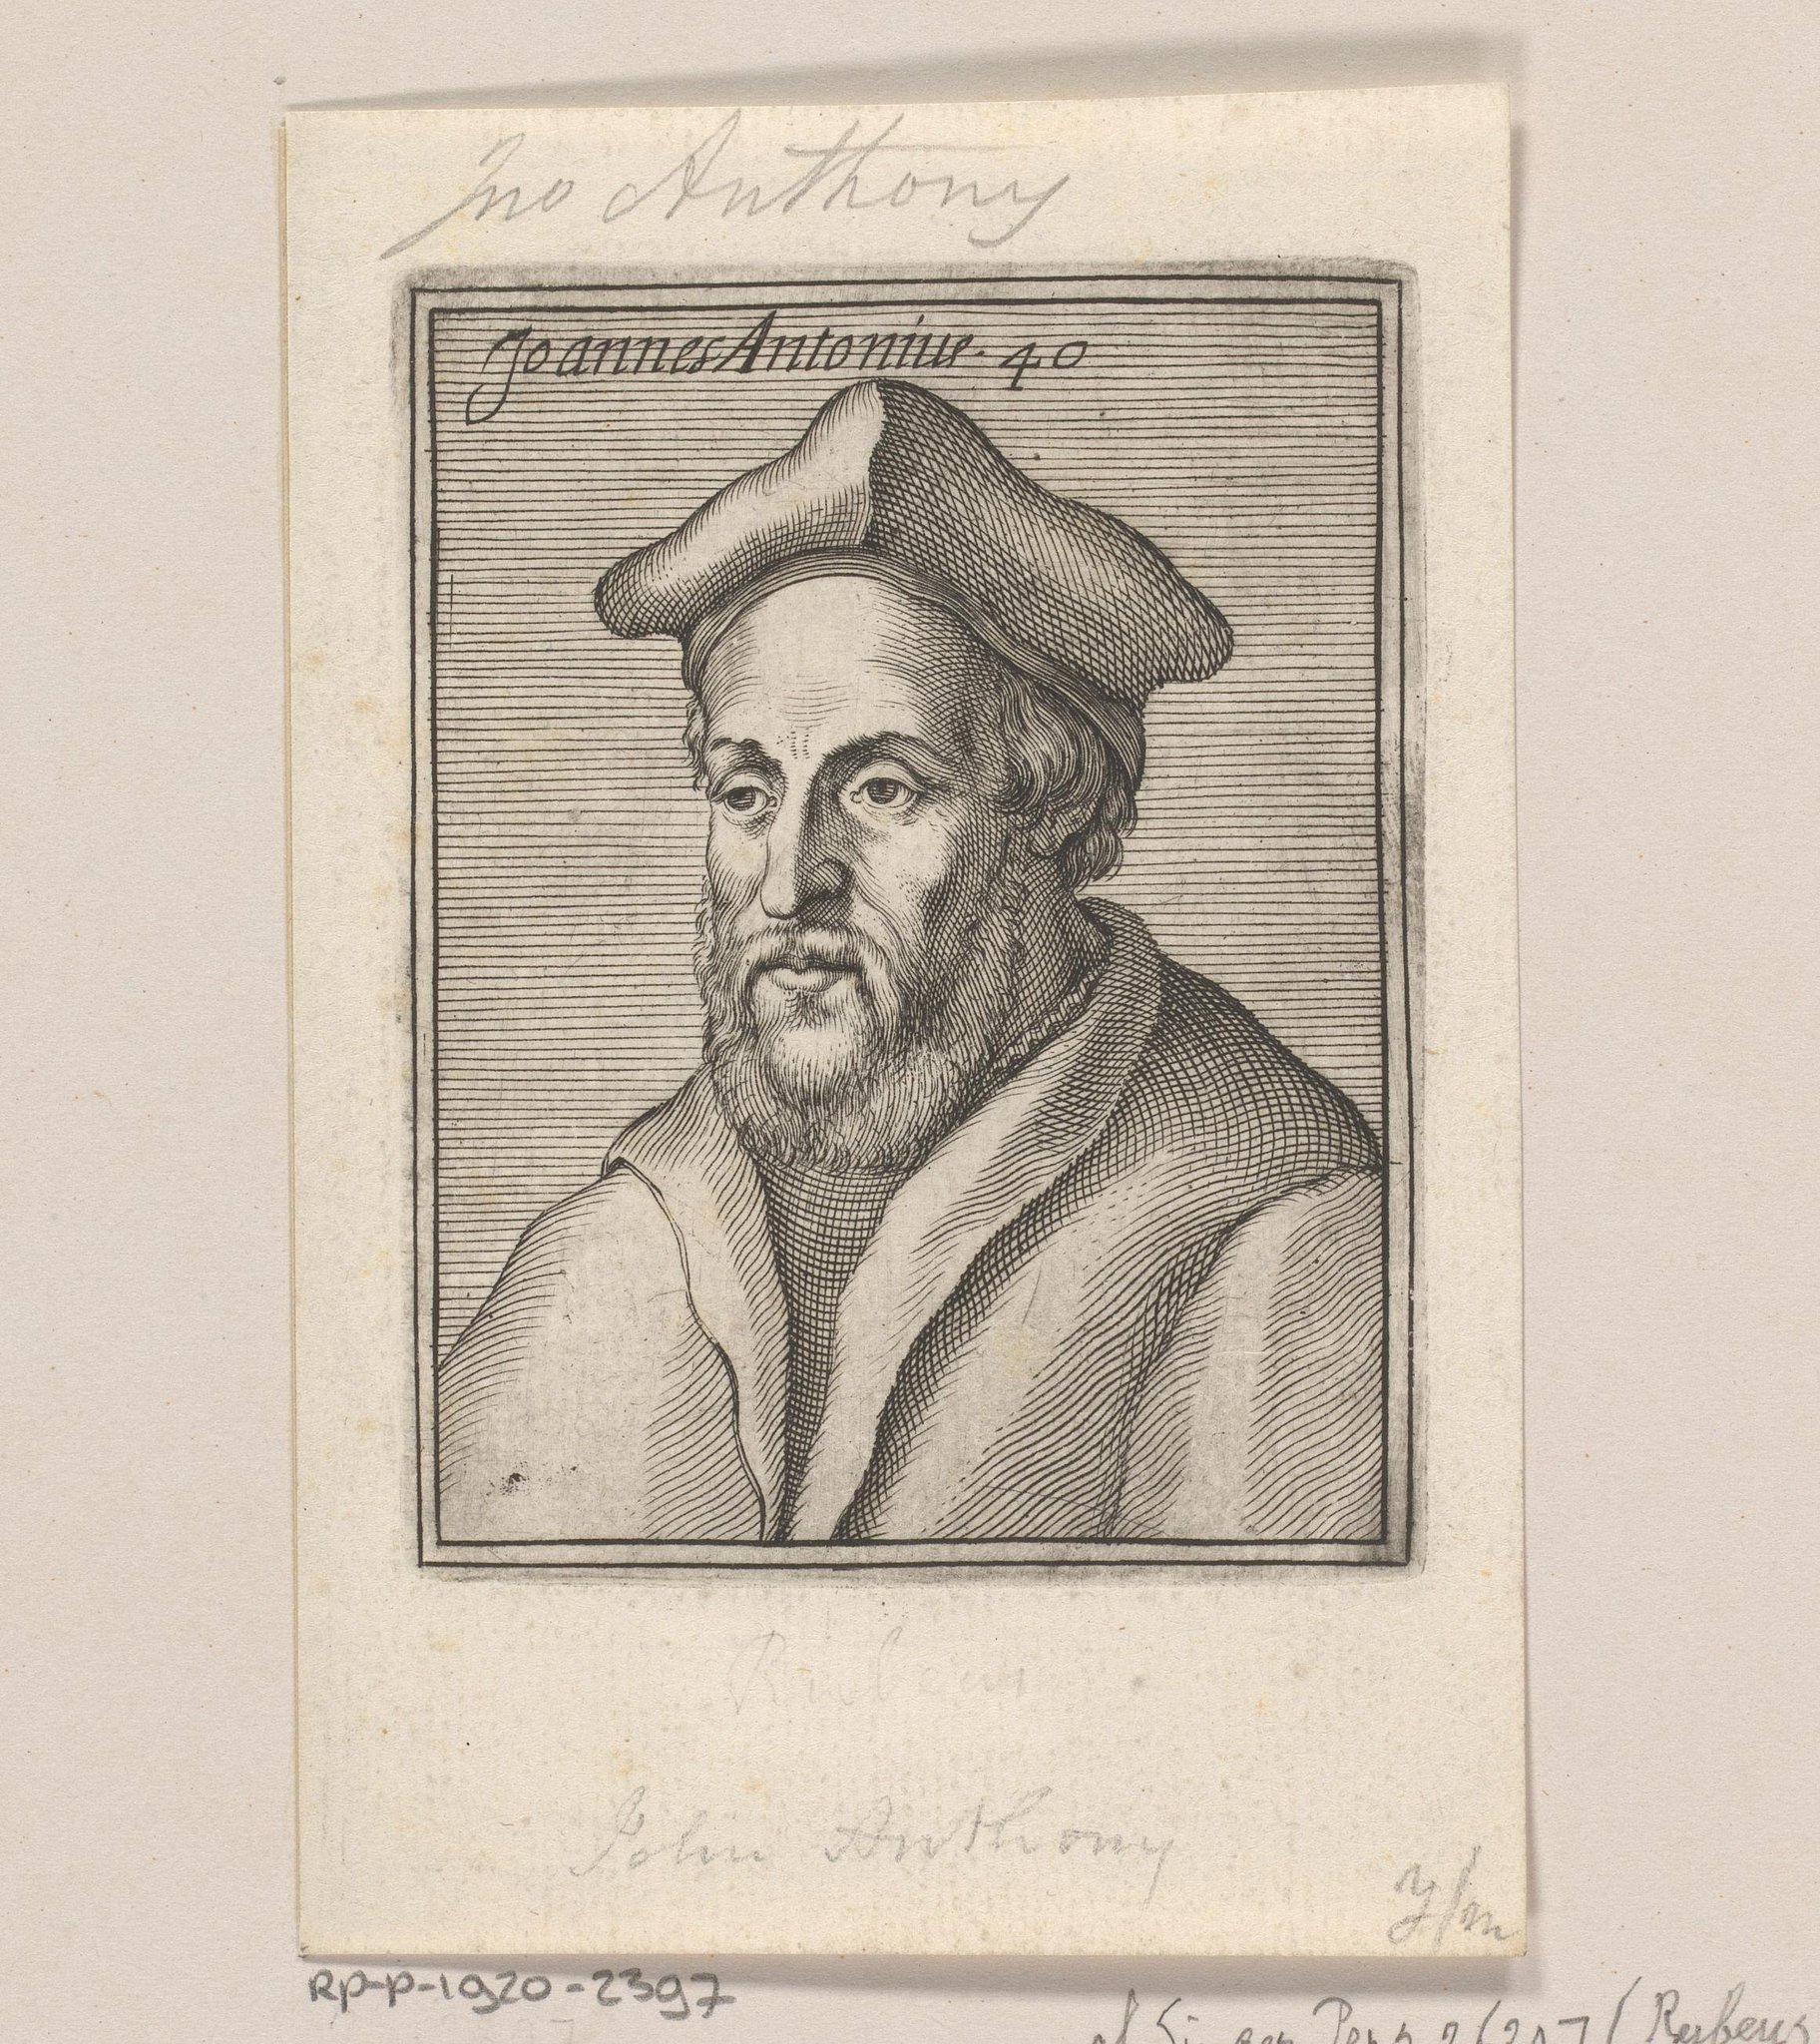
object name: print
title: Portretten van wetenschappers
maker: Anonymous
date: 1625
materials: paper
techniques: engraving, intaglio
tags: historical persons, portrait of a writer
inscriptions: collector's mark: Lugt 2228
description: Prent mogelijk uit: Pernet, Claude. Illustrissimorum, omnique virtutis, et scientiarum laude praestantissimorv. virorum icones. Rome: s.n., 1625.